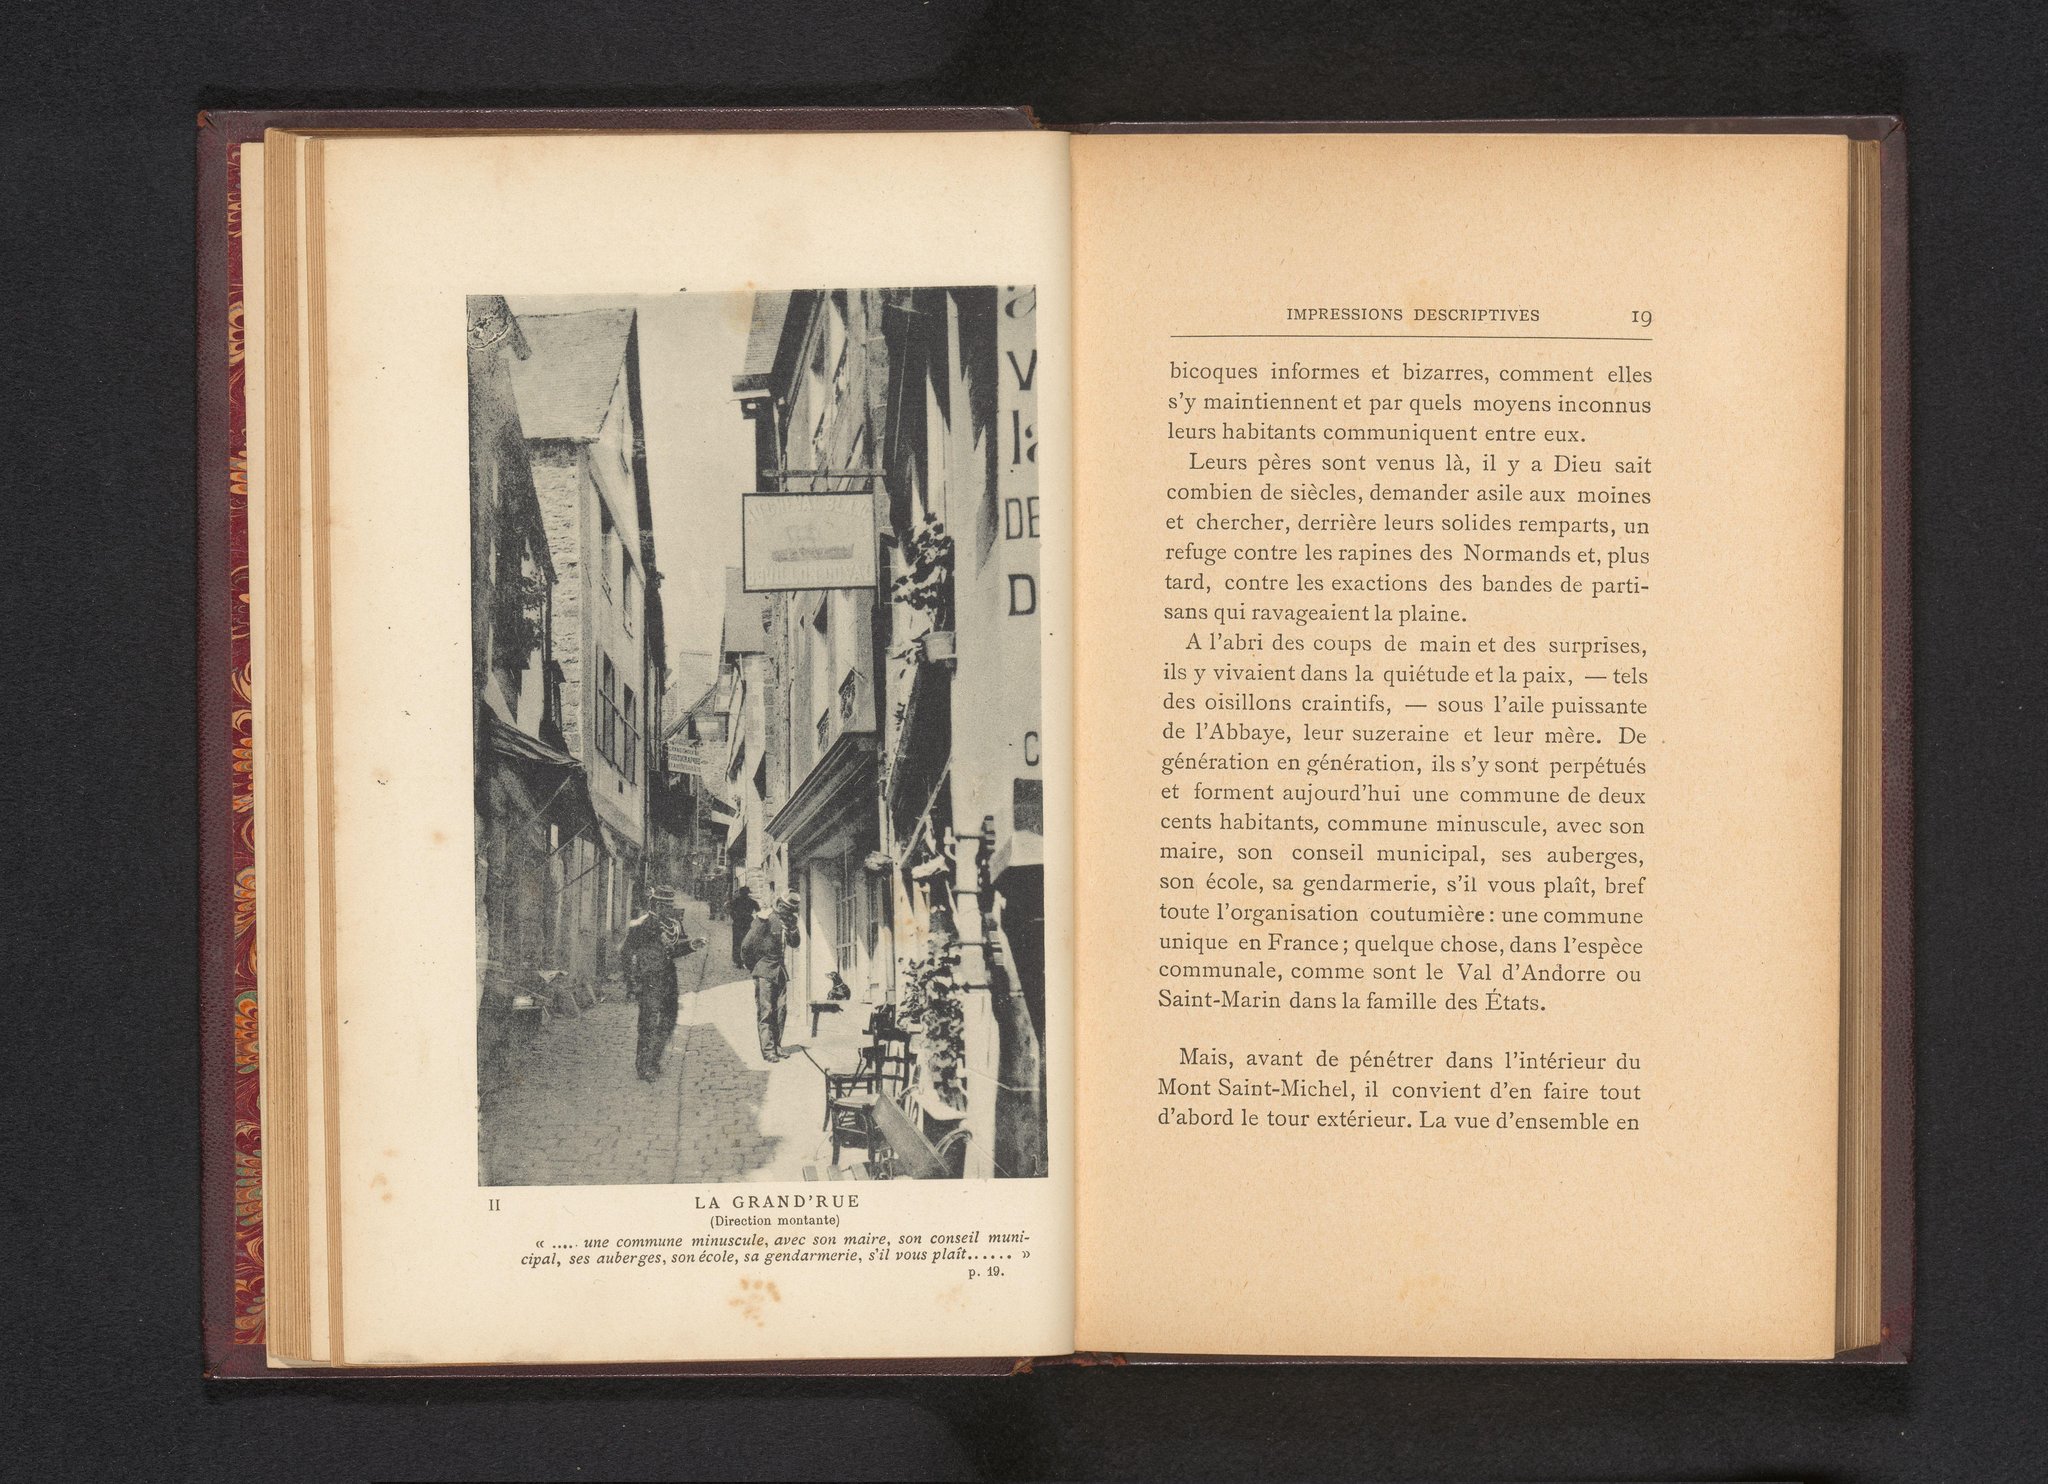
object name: page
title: Gezicht op de Grande Rue te Mont Saint-Michel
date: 1892-1897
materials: paper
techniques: photograph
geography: mont-saint-michel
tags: street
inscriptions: inscription: ‘Direction montante/ une commune miniscule, avec son maire, son conseil municipal, ses auberges, son école, sa gendarmerie, s'il vous plaît’